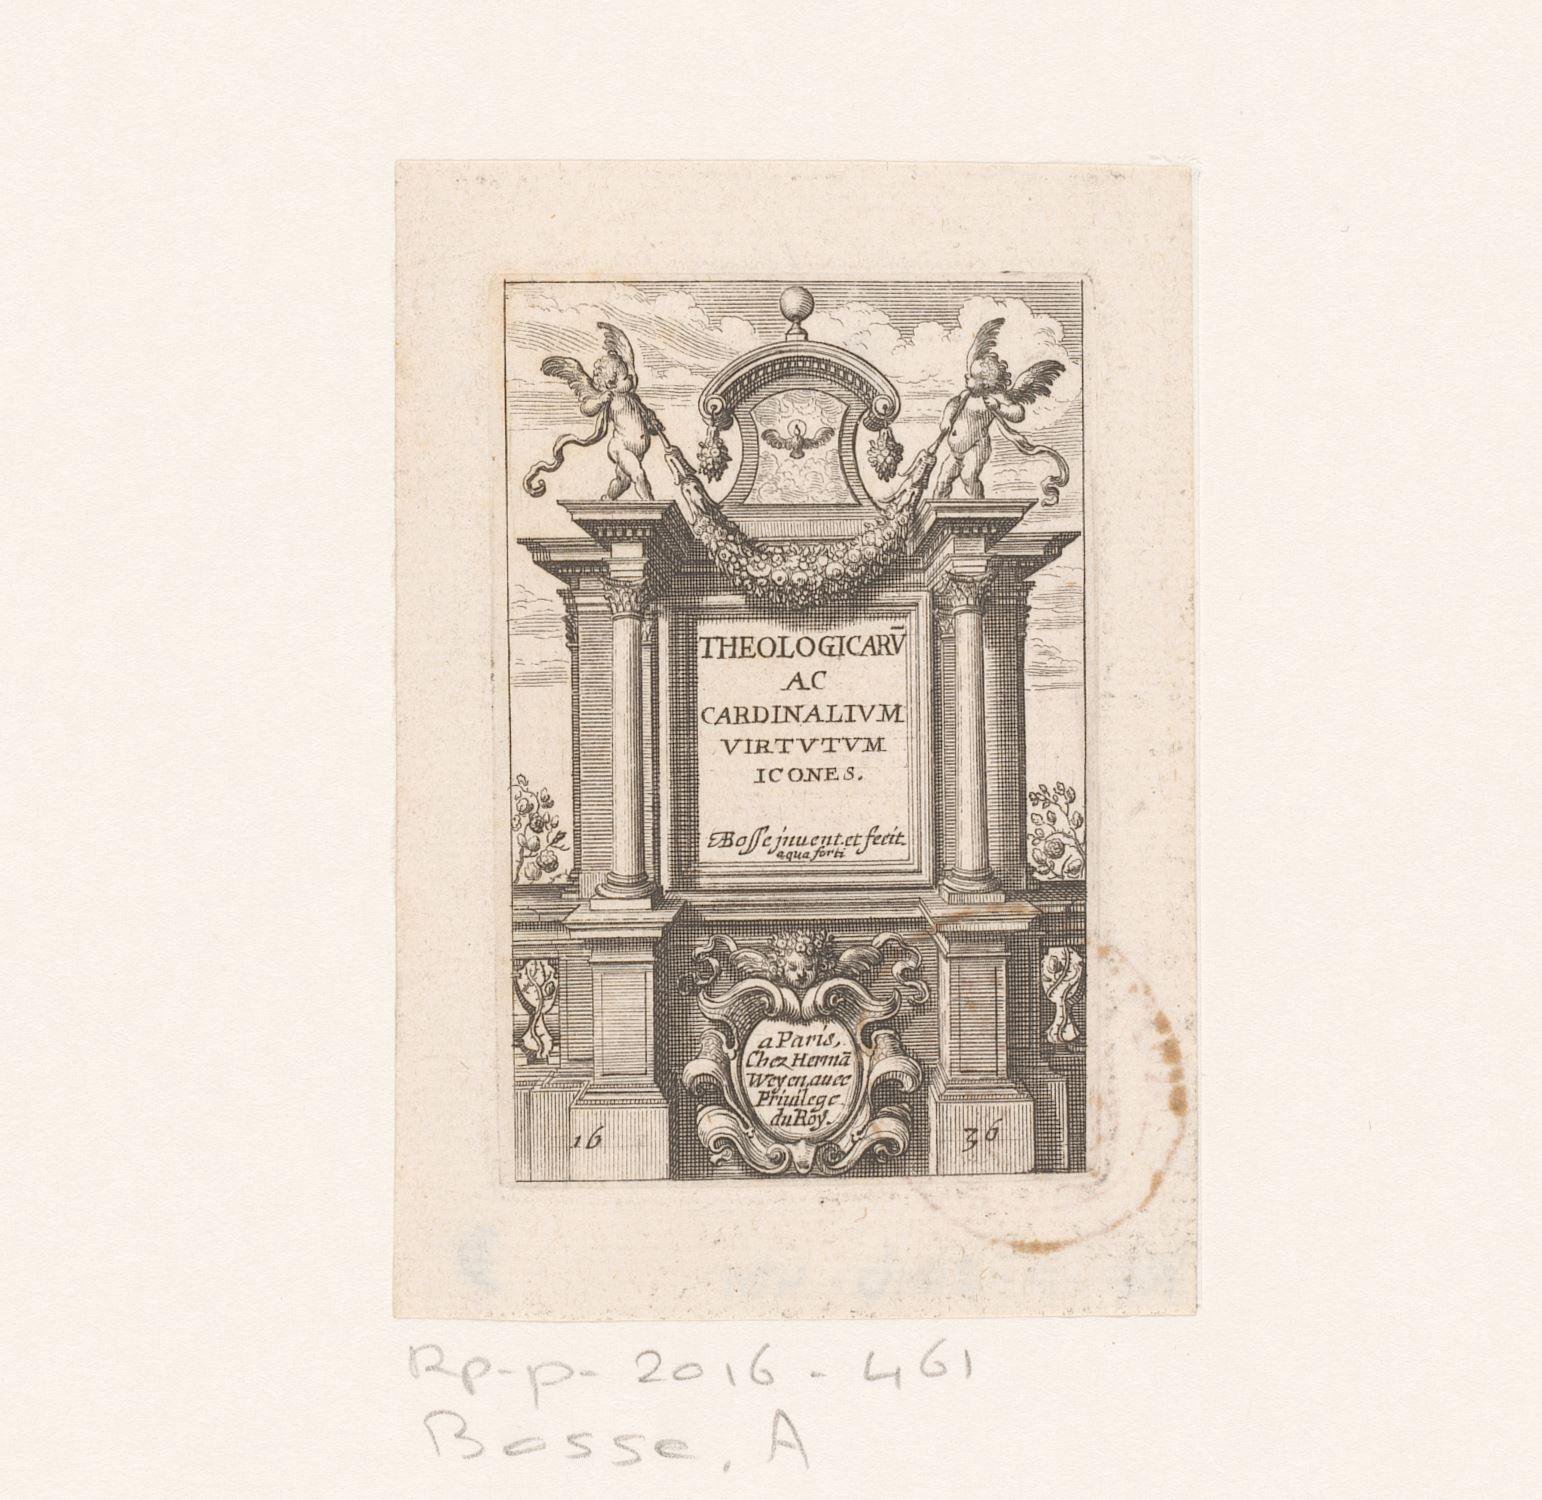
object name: print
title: Titelprent met architecturale omlijsting en putti met een guirlande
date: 1636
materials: paper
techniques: engraving, etching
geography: paris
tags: architectural representations in general, ornament ~ festoon, garland, cupids: 'amores', 'amoretti', 'putti'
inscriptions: collector's mark: Lugt 240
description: Titelprent voor een serie van negen prenten (inclusief een titelprent met opdracht en een tweede titelprent) met personificaties van de zeven deugden.